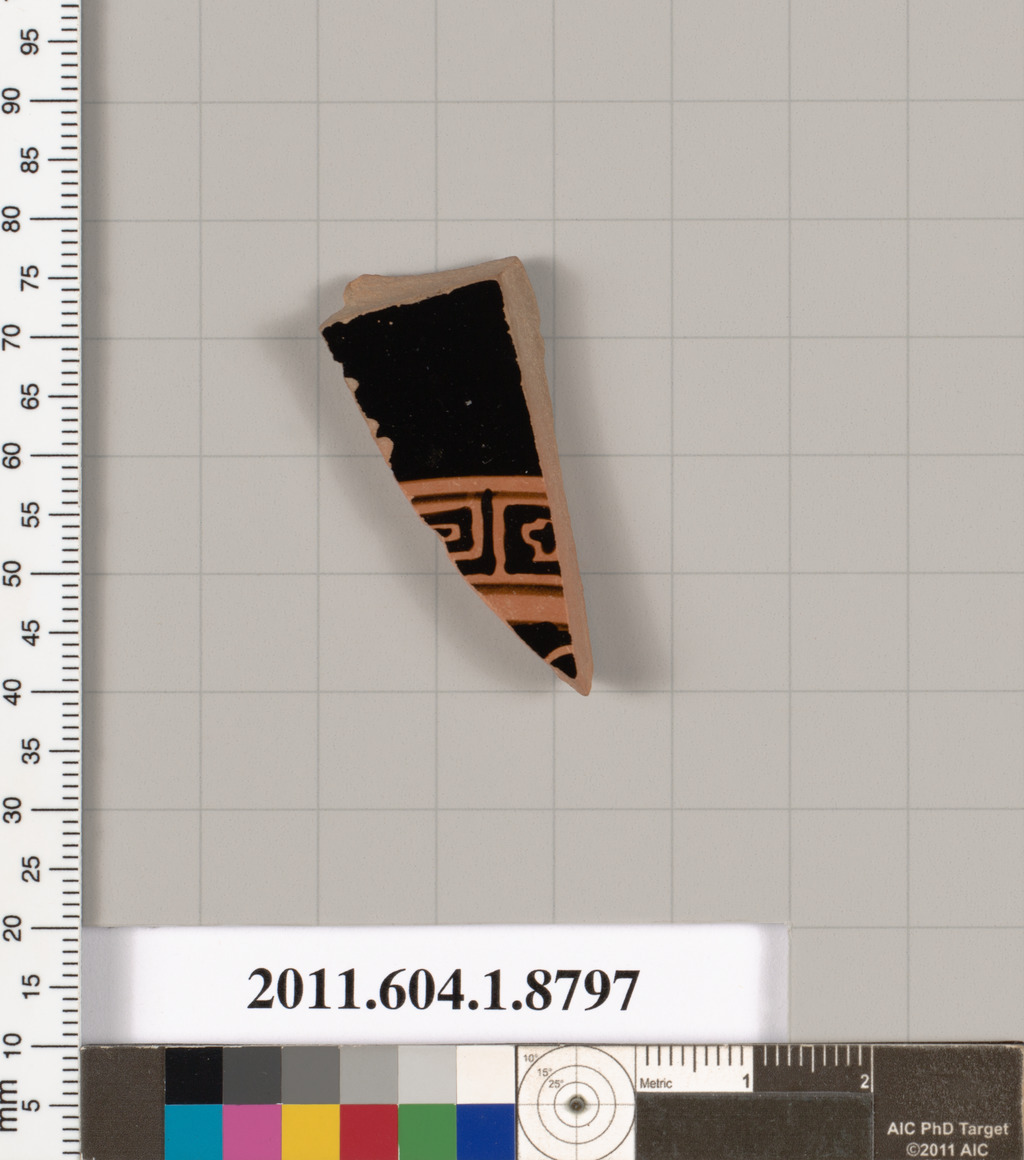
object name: kylix fragment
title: Terracotta fragment of a kylix (drinking cup)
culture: greek, attic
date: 490-480 BCE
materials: terracotta